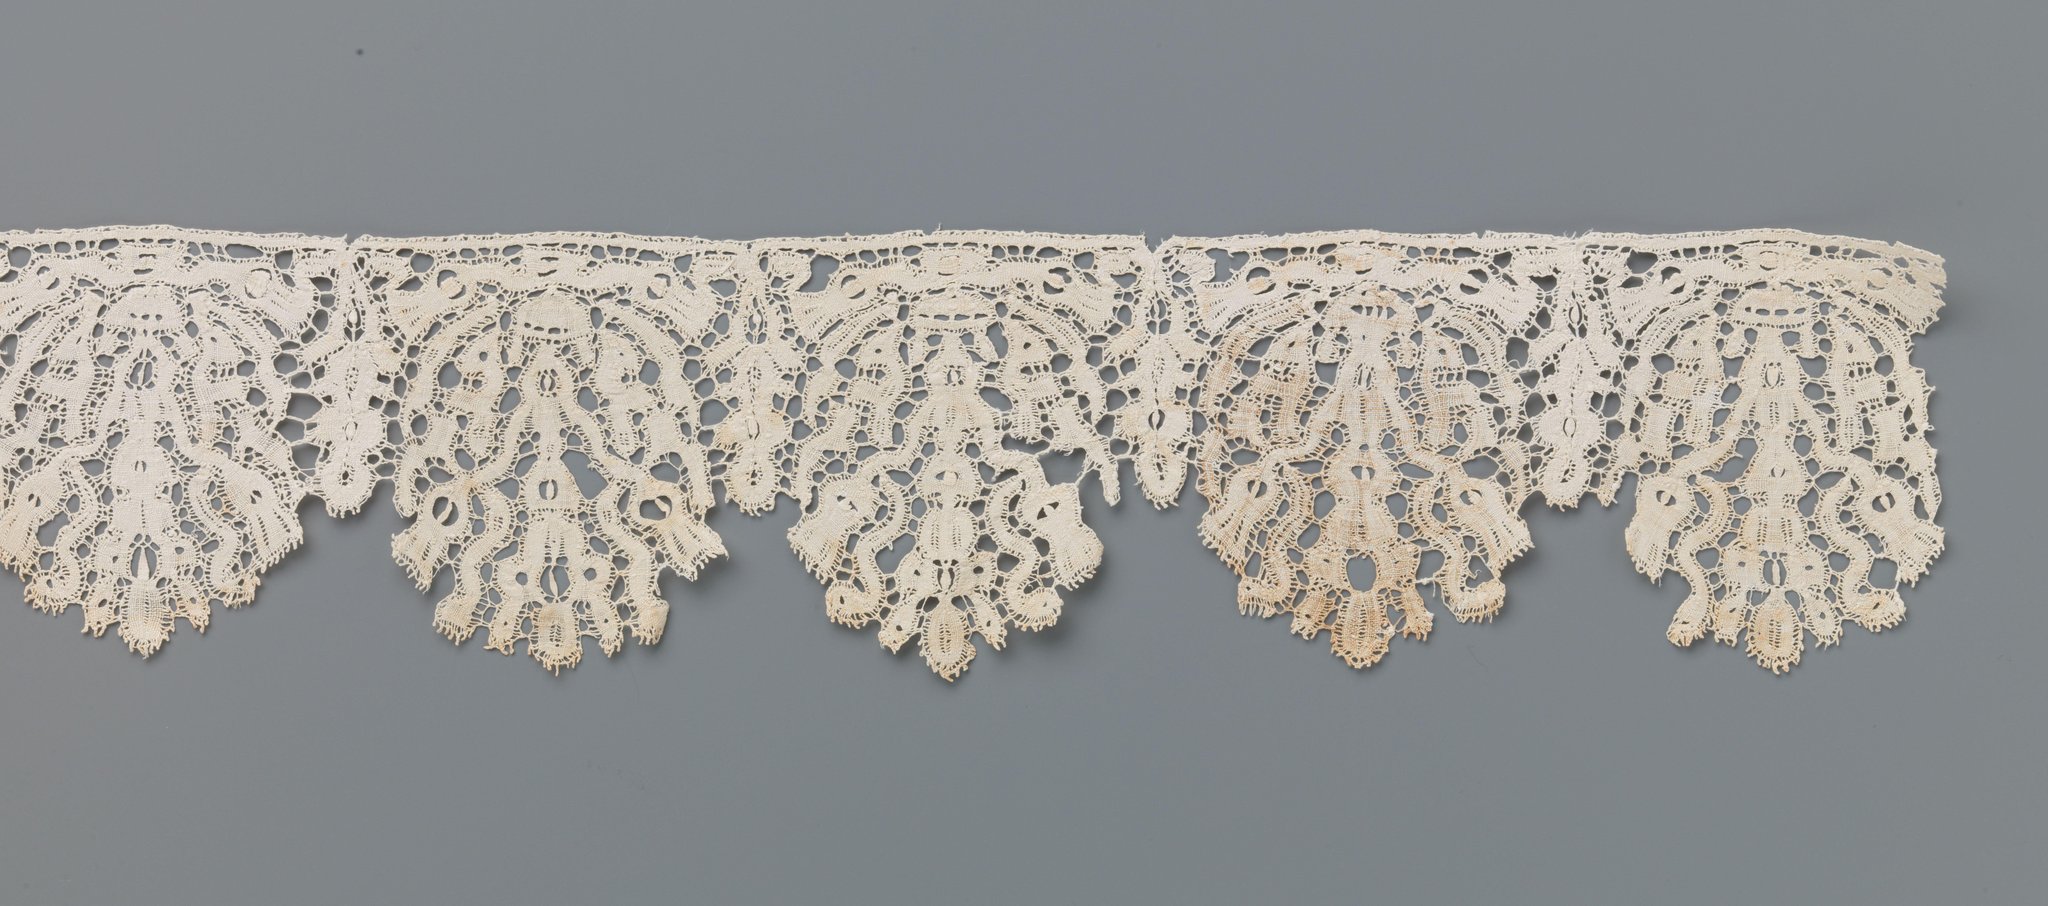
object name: strip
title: Strook kloskant met distels in bloempot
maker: Anonymous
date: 1625-1649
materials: linen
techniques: lace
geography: southern netherlands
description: Strook naturelkleurige kloskant, oudvlaamse kant. De schulpen waaruit de strook is opgebouwd zijn halfrond met grillig gevormde randen. De schulpen ontstaan vanuit een zich herhalend symmetrisch motief van een bloempot waarin onder andere distels staan. Ten opzichte van de rechte bovenrand hangt de bloempot op de kop. De motieven zijn gemaakt in linnenslag met in de uitsparingen op verschillende plaatsen blaadjes gemaakt in vormslag.